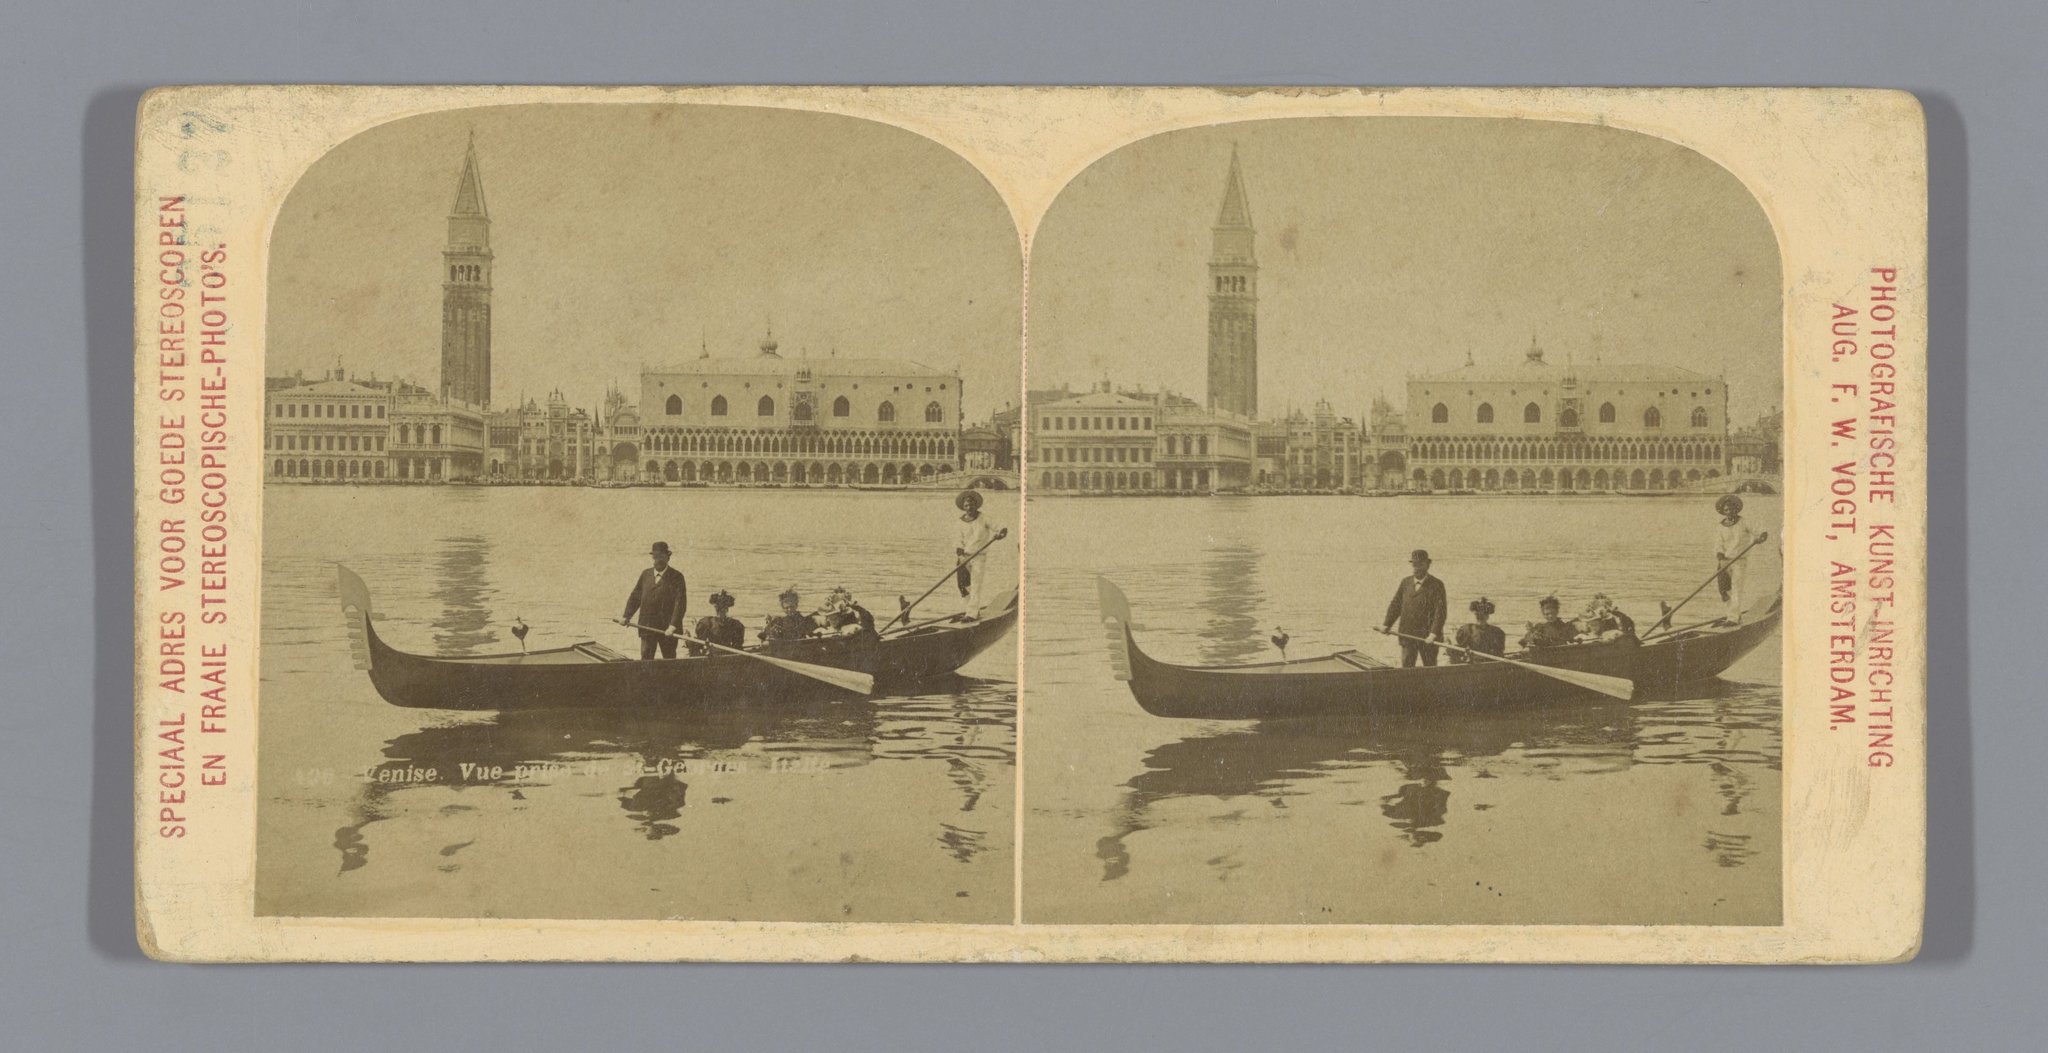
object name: stereograph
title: Gezicht op Venetië, met op de voorgrond een gezelschap in een gondel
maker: Anonymous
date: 1870-1900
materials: cardboard, photographic support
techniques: albumen print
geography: isola di san giorgio maggiore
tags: city-view in general; 'veduta', gondola (+ four persons or more ~ traffic and transport), venice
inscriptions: name: ‘PHOTOGRAFISCHE KUNST-INRICHTING AUG. F. W. VOGT, AMSTERDAM. SPECIAAL ADRES VOOR GOEDE STEREOSCOPEN EN FRAAIE STEREOSCOPISCHE-PHOTO'S.’, number: ‘406’